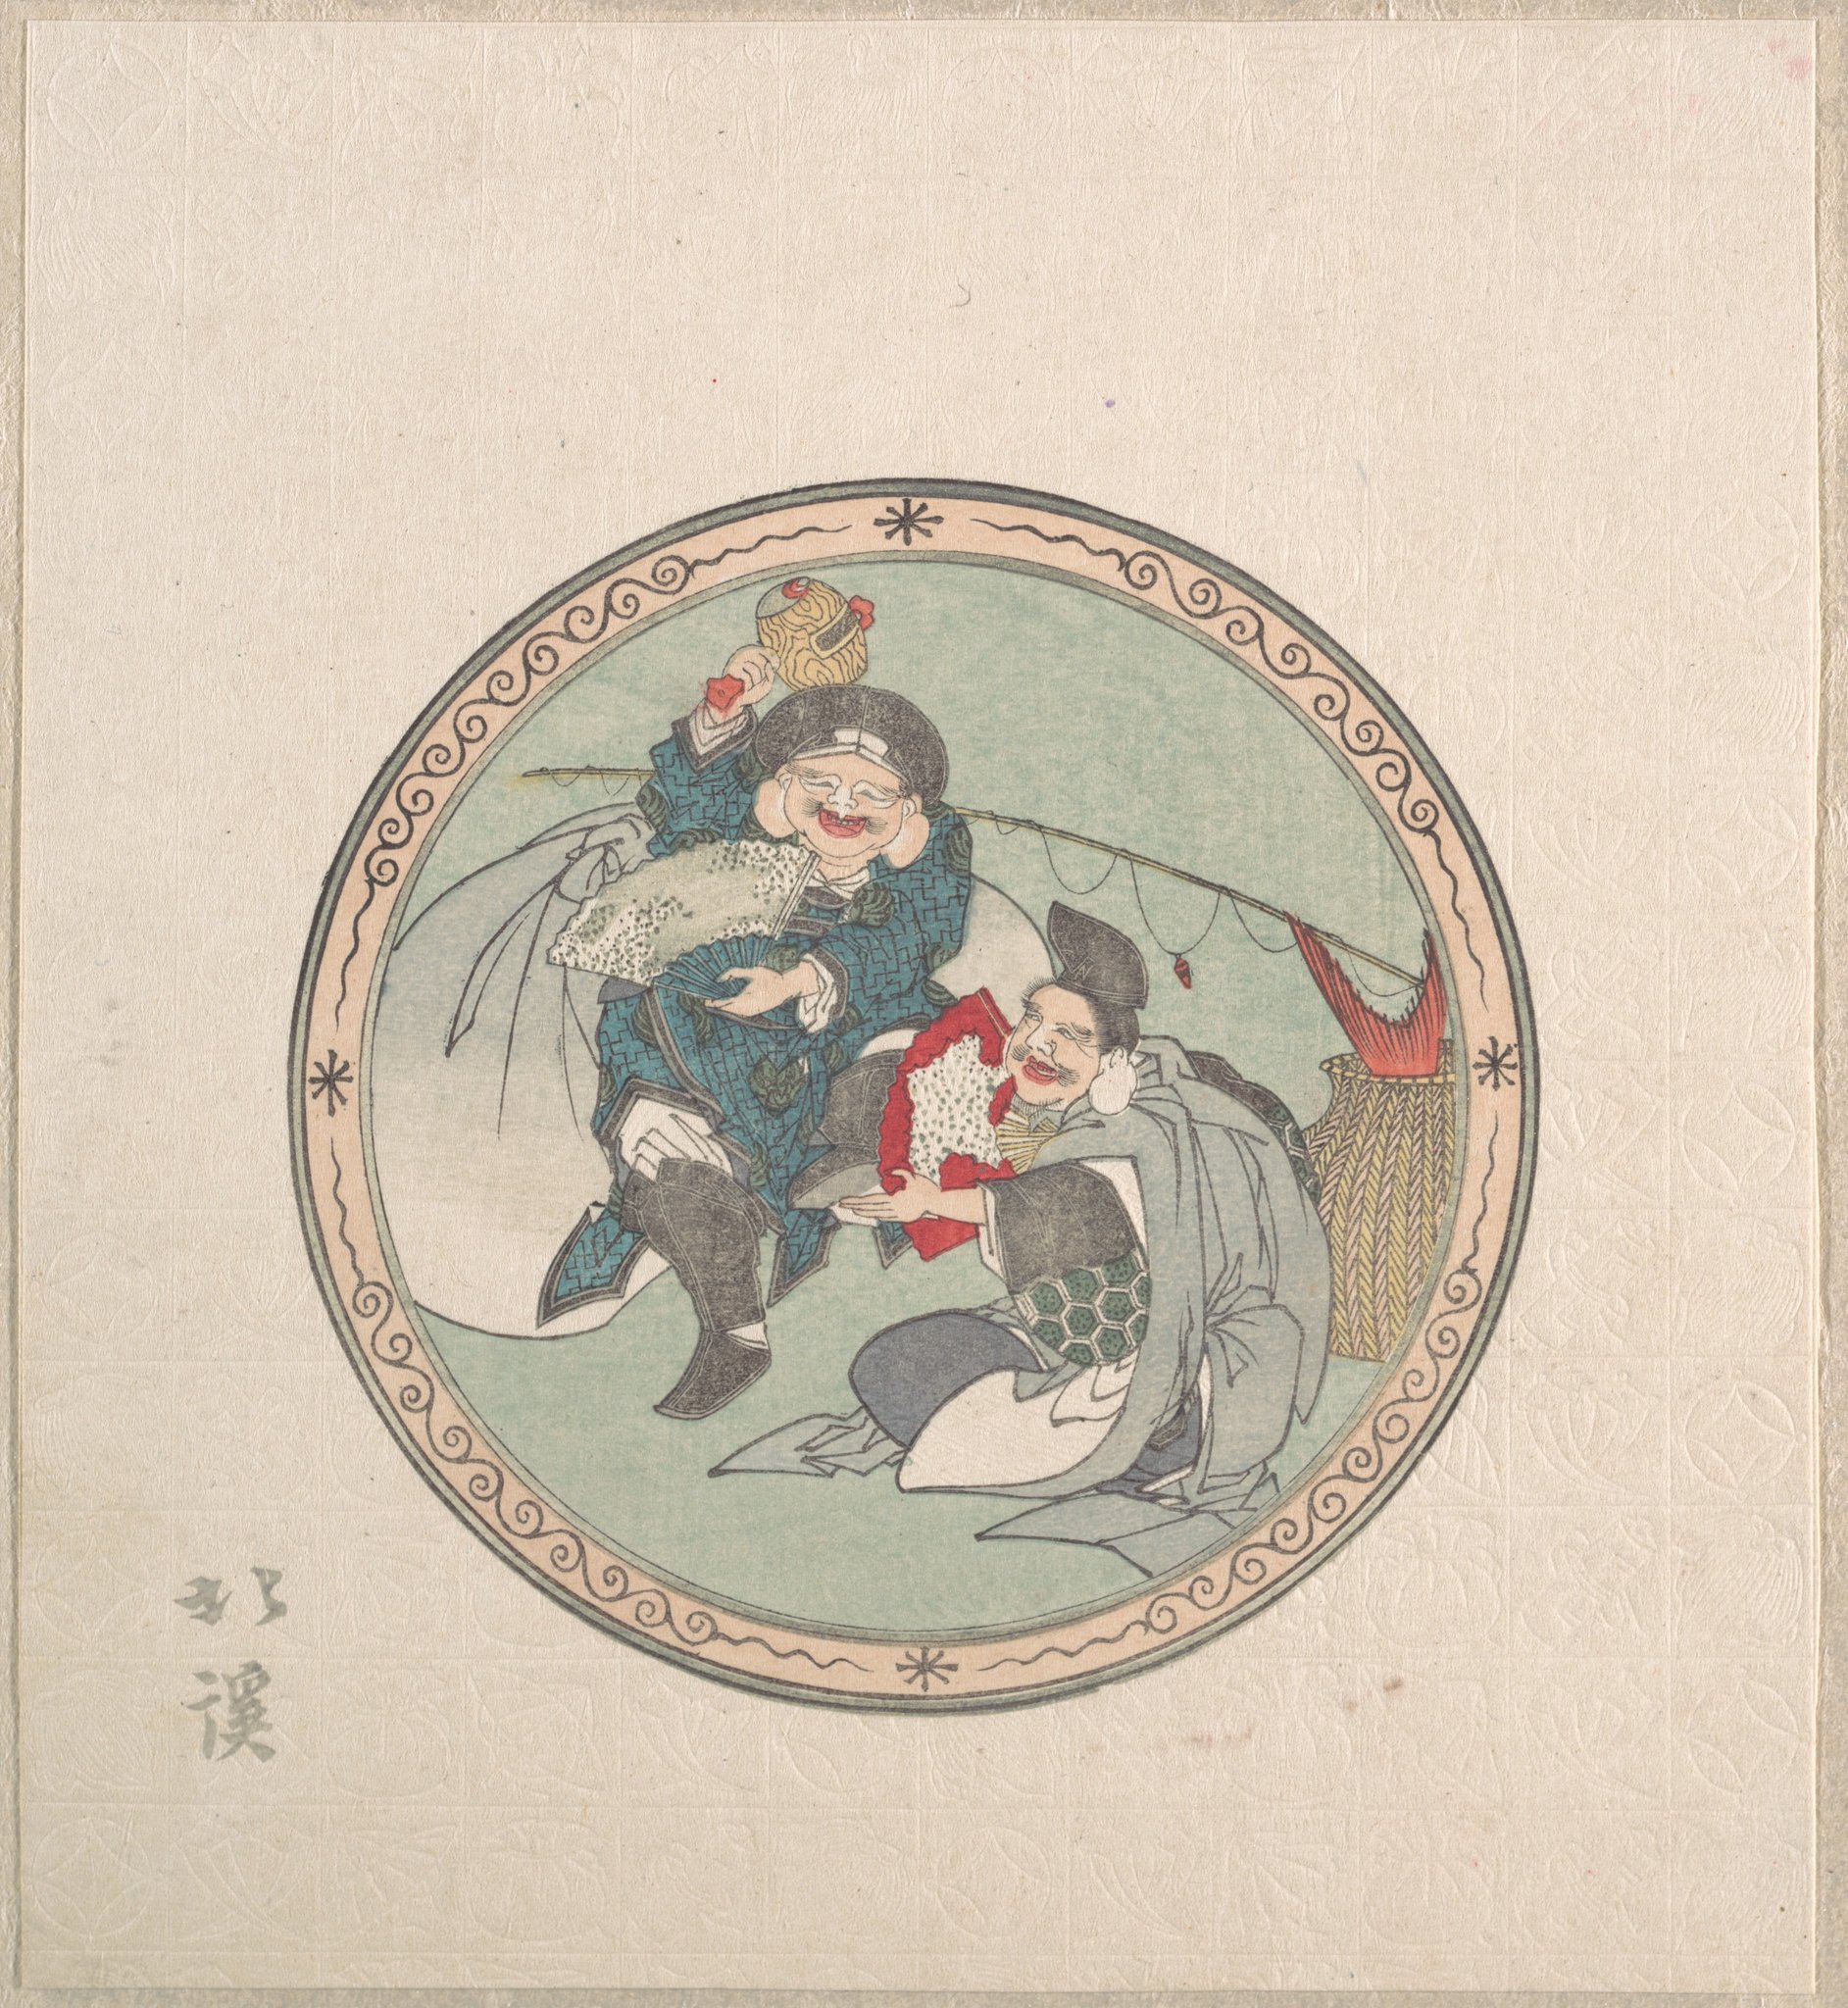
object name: print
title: Ebisu and Daikoku; Two of the Seven Gods of Good Fortune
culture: japanese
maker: totoya hokkei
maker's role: artist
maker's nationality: japanese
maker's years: 1780-1850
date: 1801-1900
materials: ink, paper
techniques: surimono, woodblock print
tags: gods